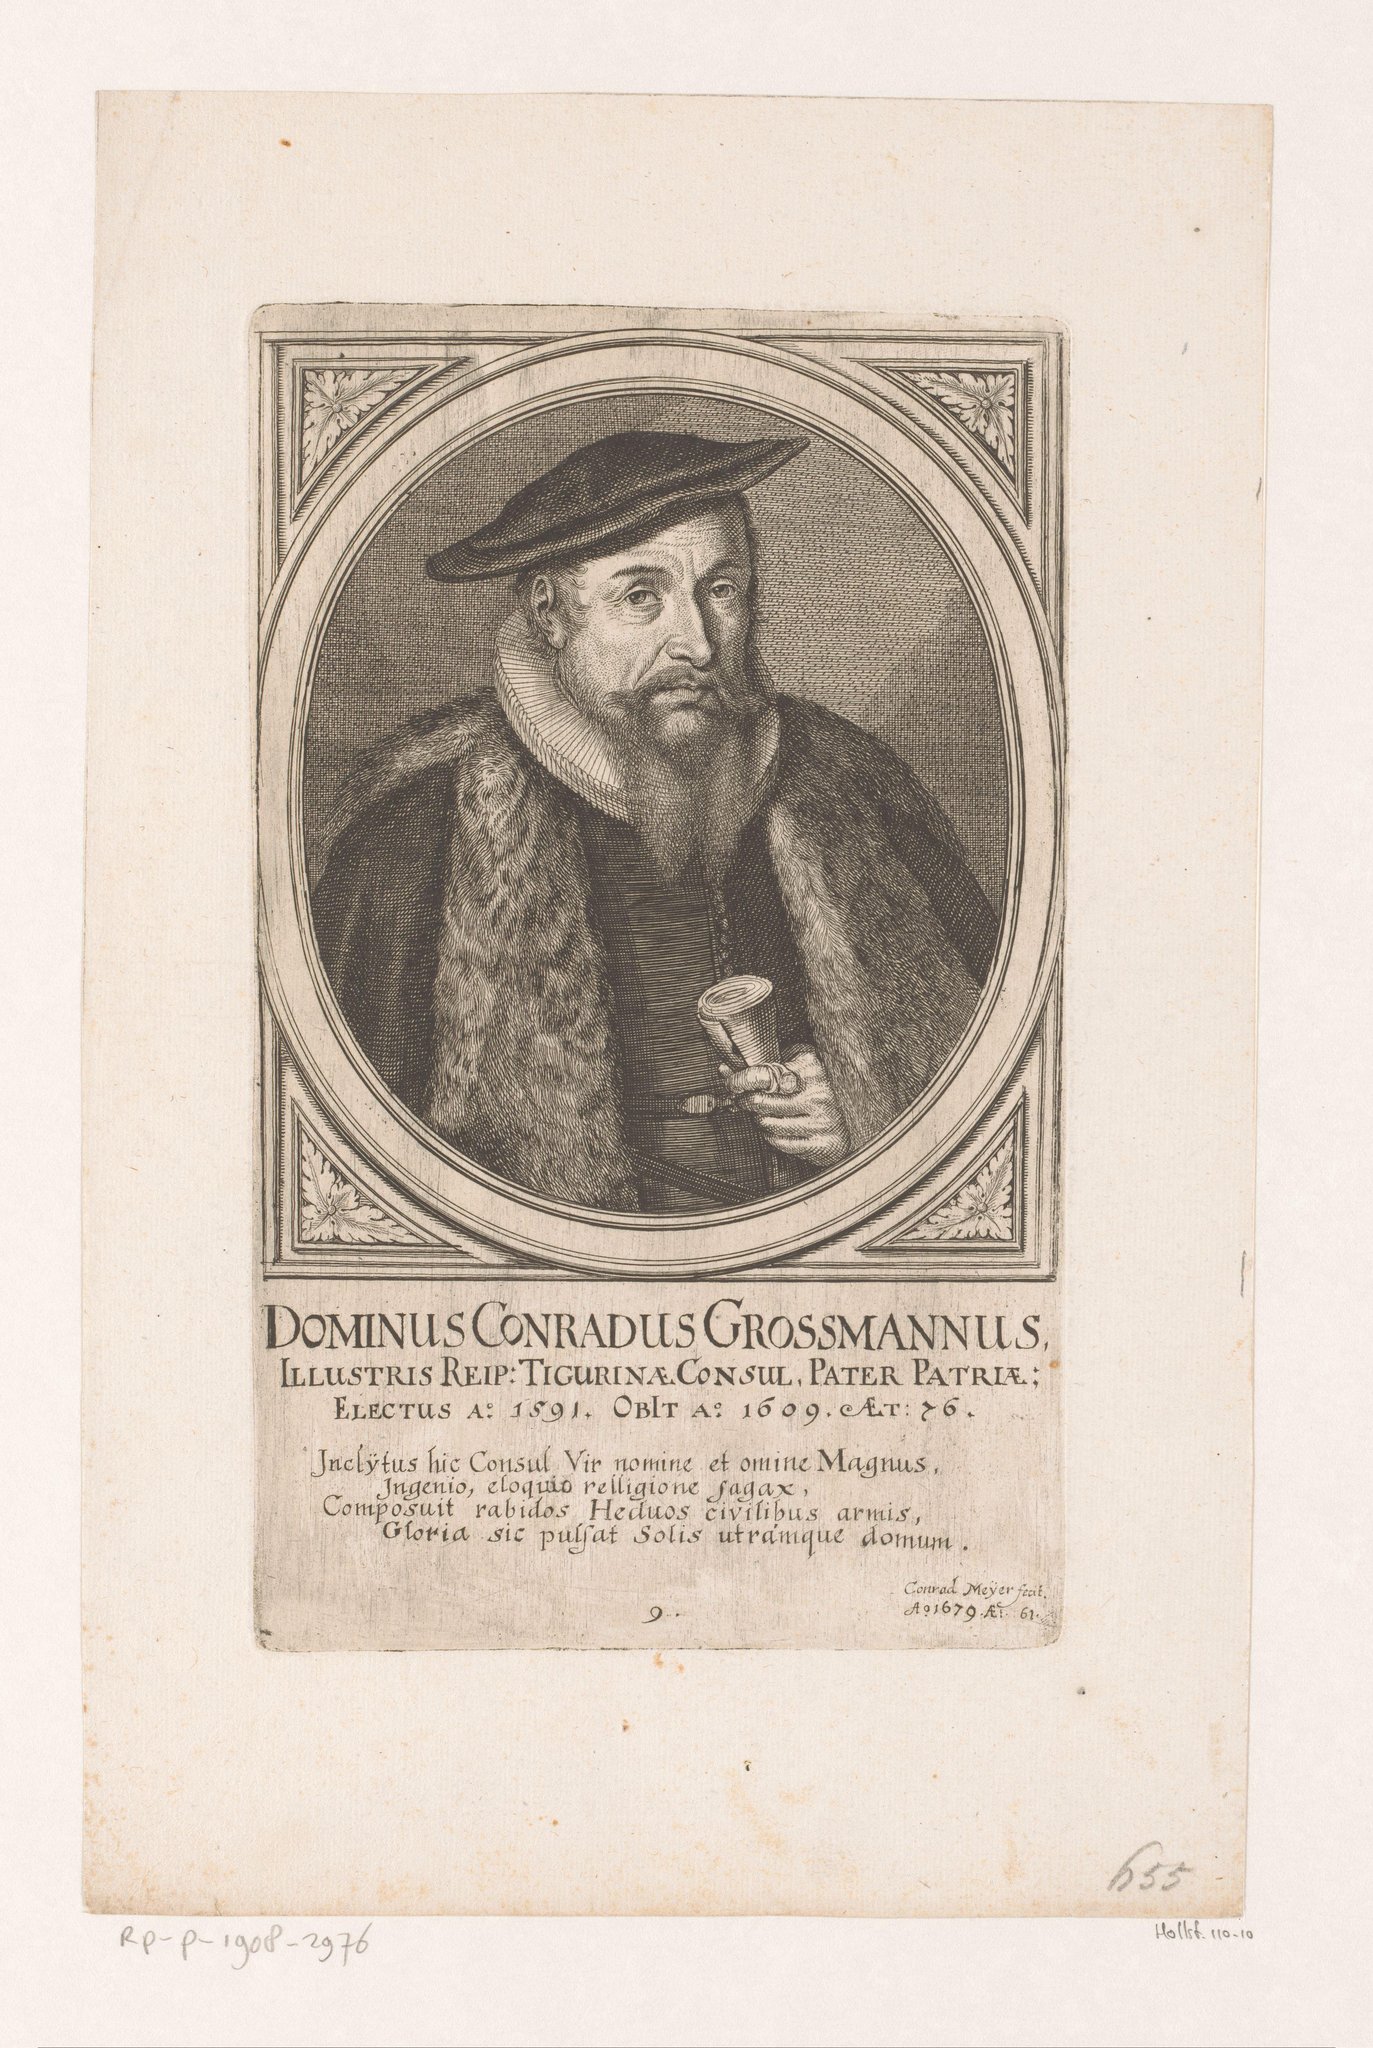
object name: print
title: Portret van Conrad Grossmann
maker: conrad meyer (i)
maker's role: painter, print maker, publisher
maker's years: 1618-1689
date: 1679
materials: paper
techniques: engraving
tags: historical persons, scroll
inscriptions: collector's mark: Lugt 2228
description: Onderdeel van een serie van 67(?) portretten van burgemeesters van Zürich. Zie Hollstein German 110, 1-26.